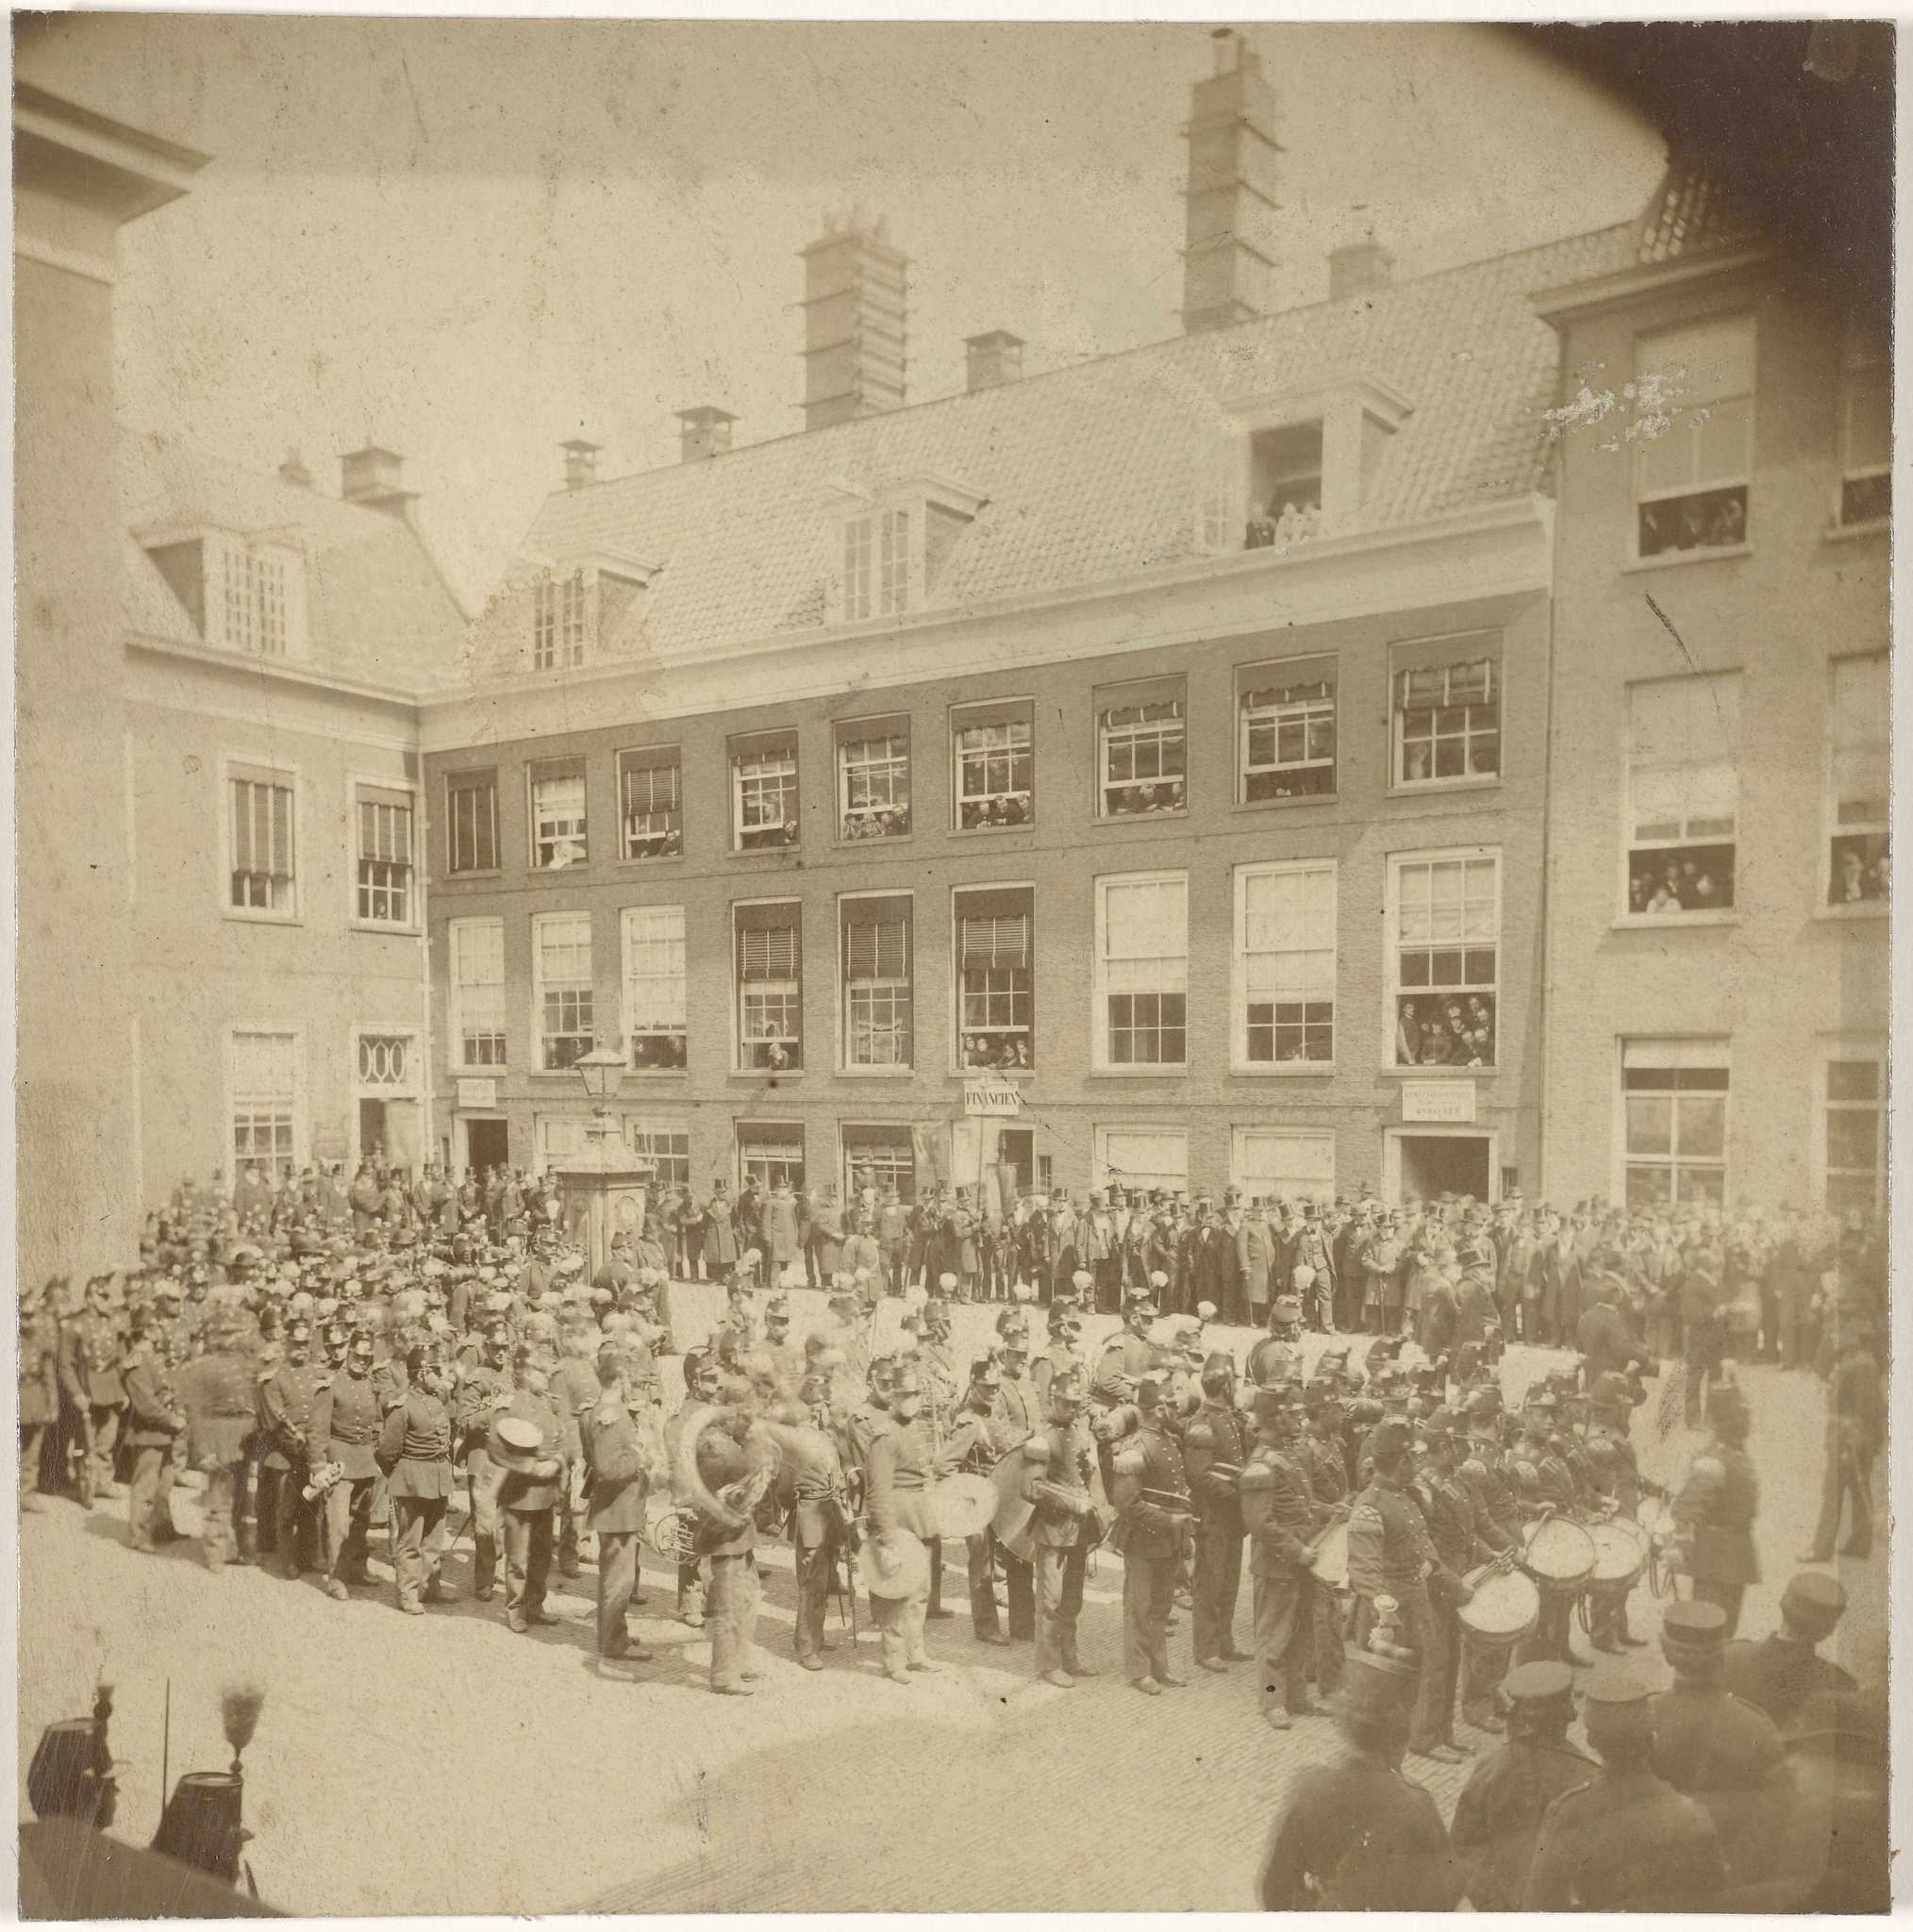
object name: photograph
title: Schutterij op de binnenplaats van het stadhuis van Amsterdam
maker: Anonymous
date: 1895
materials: cardboard, photographic support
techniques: albumen print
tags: amsterdam